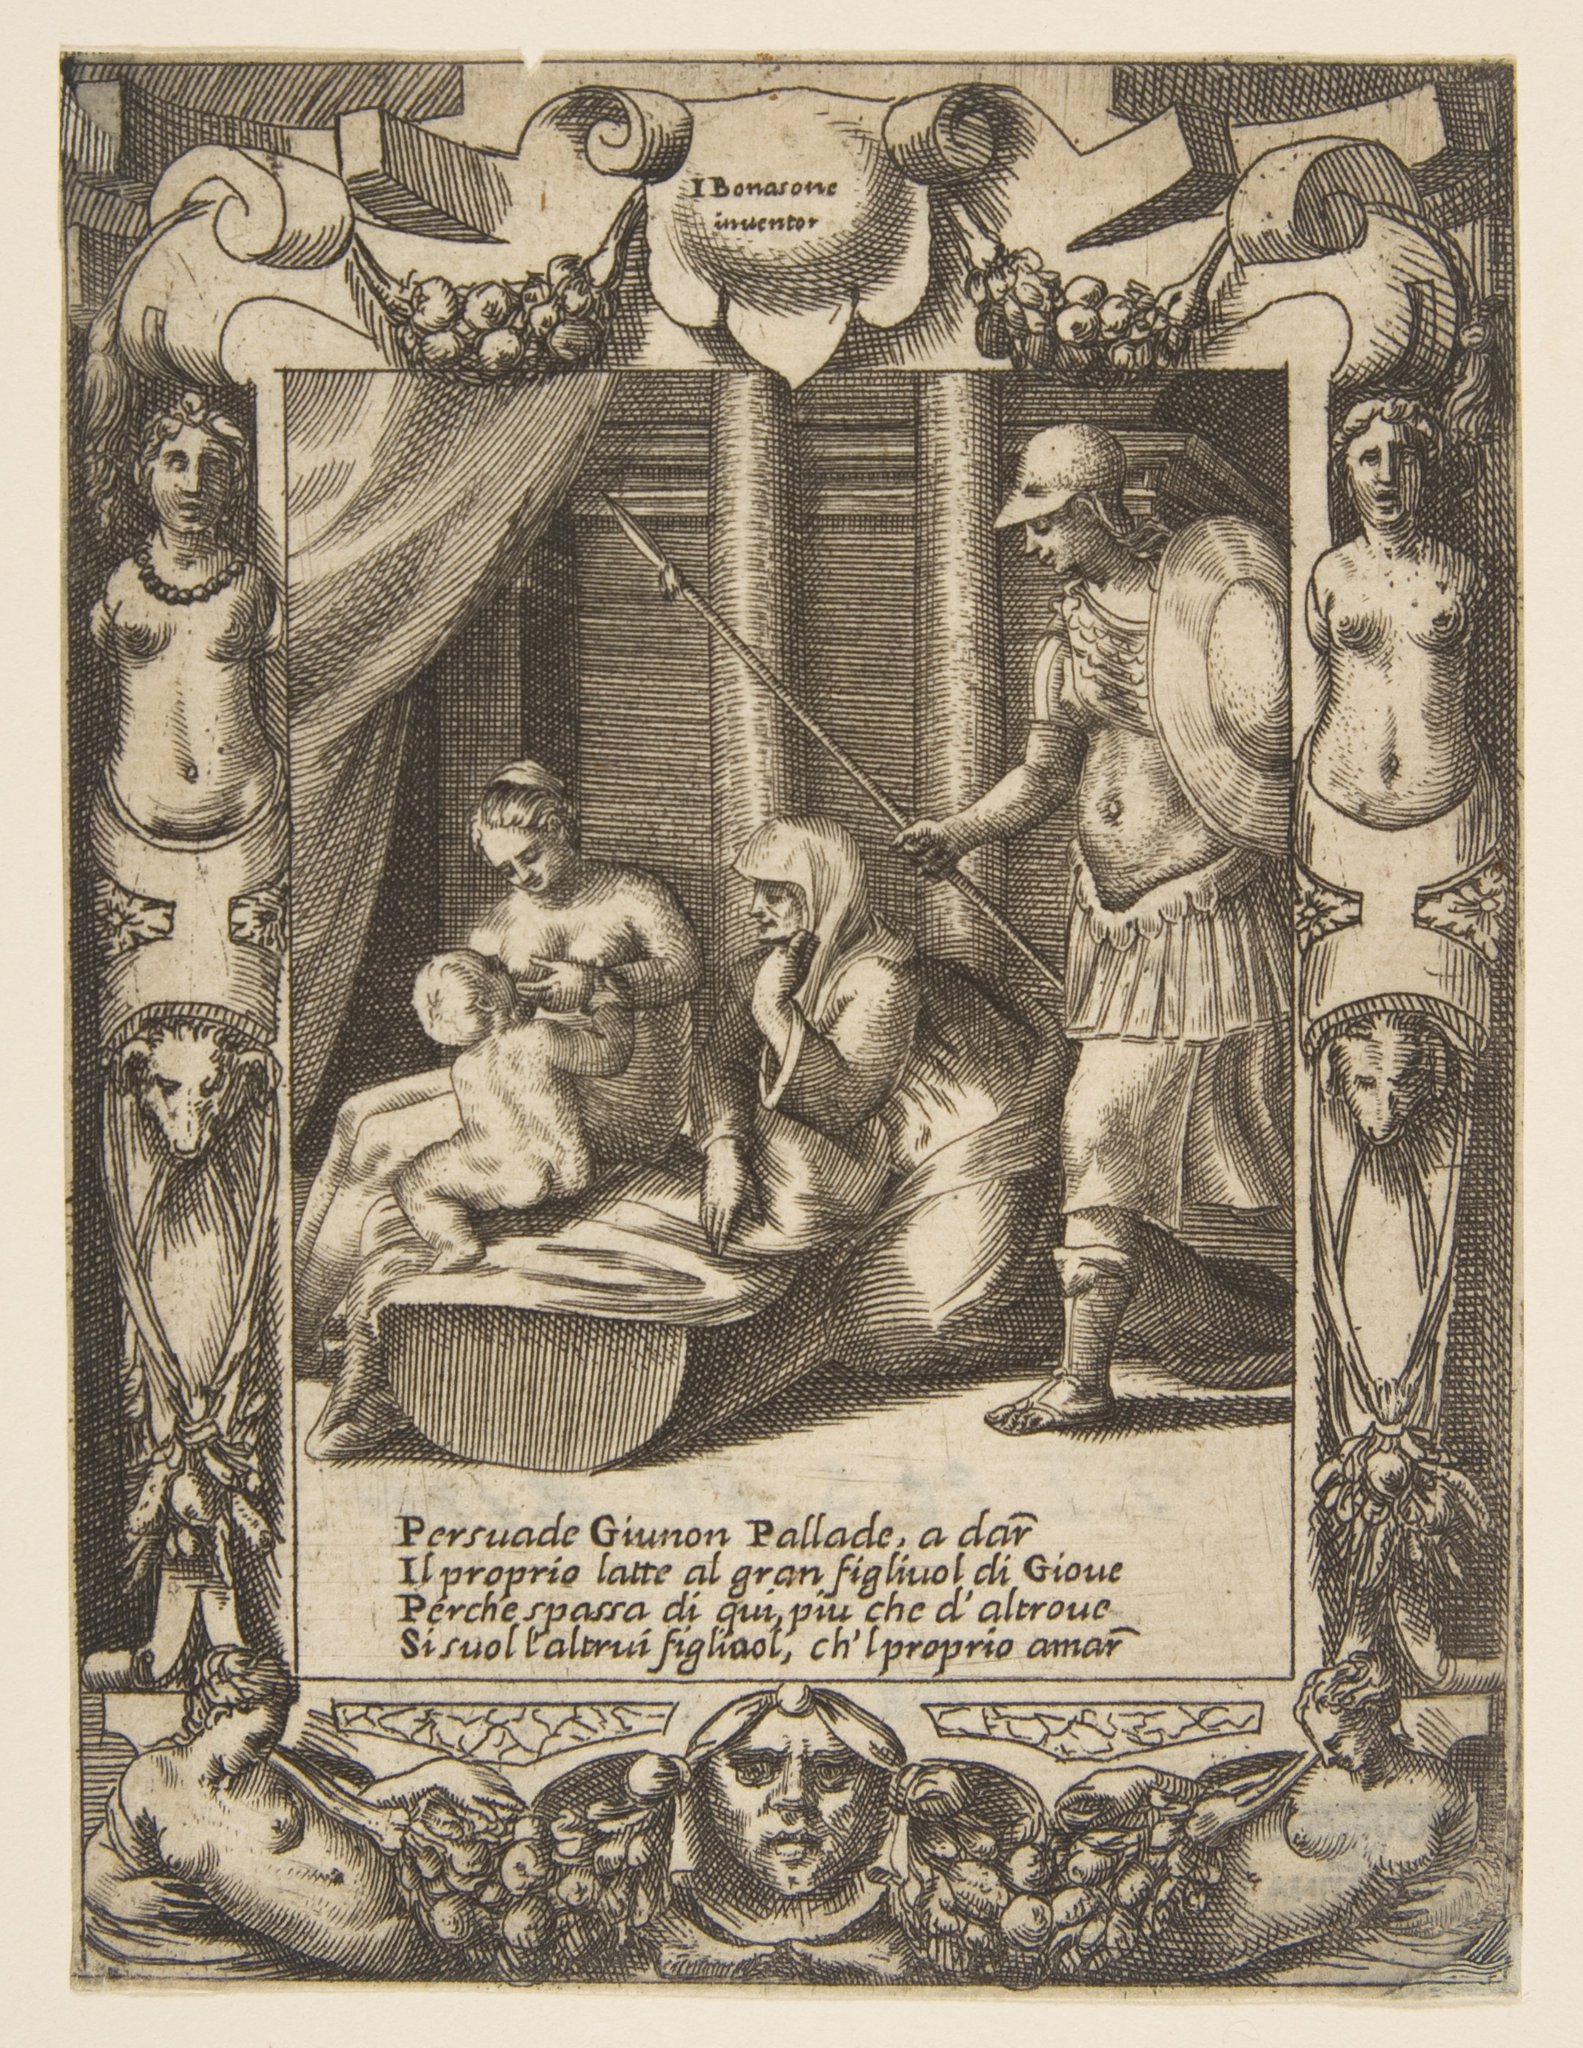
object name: print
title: Juno persuading Athena to nurse the young Hercules, set within an elaborate frame, from "Loves, Rages and Jealousies of Juno"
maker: giulio bonasone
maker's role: artist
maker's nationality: italian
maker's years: 1510-1576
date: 1531-1576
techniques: engraving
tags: female nudes,athena,hercules,juno